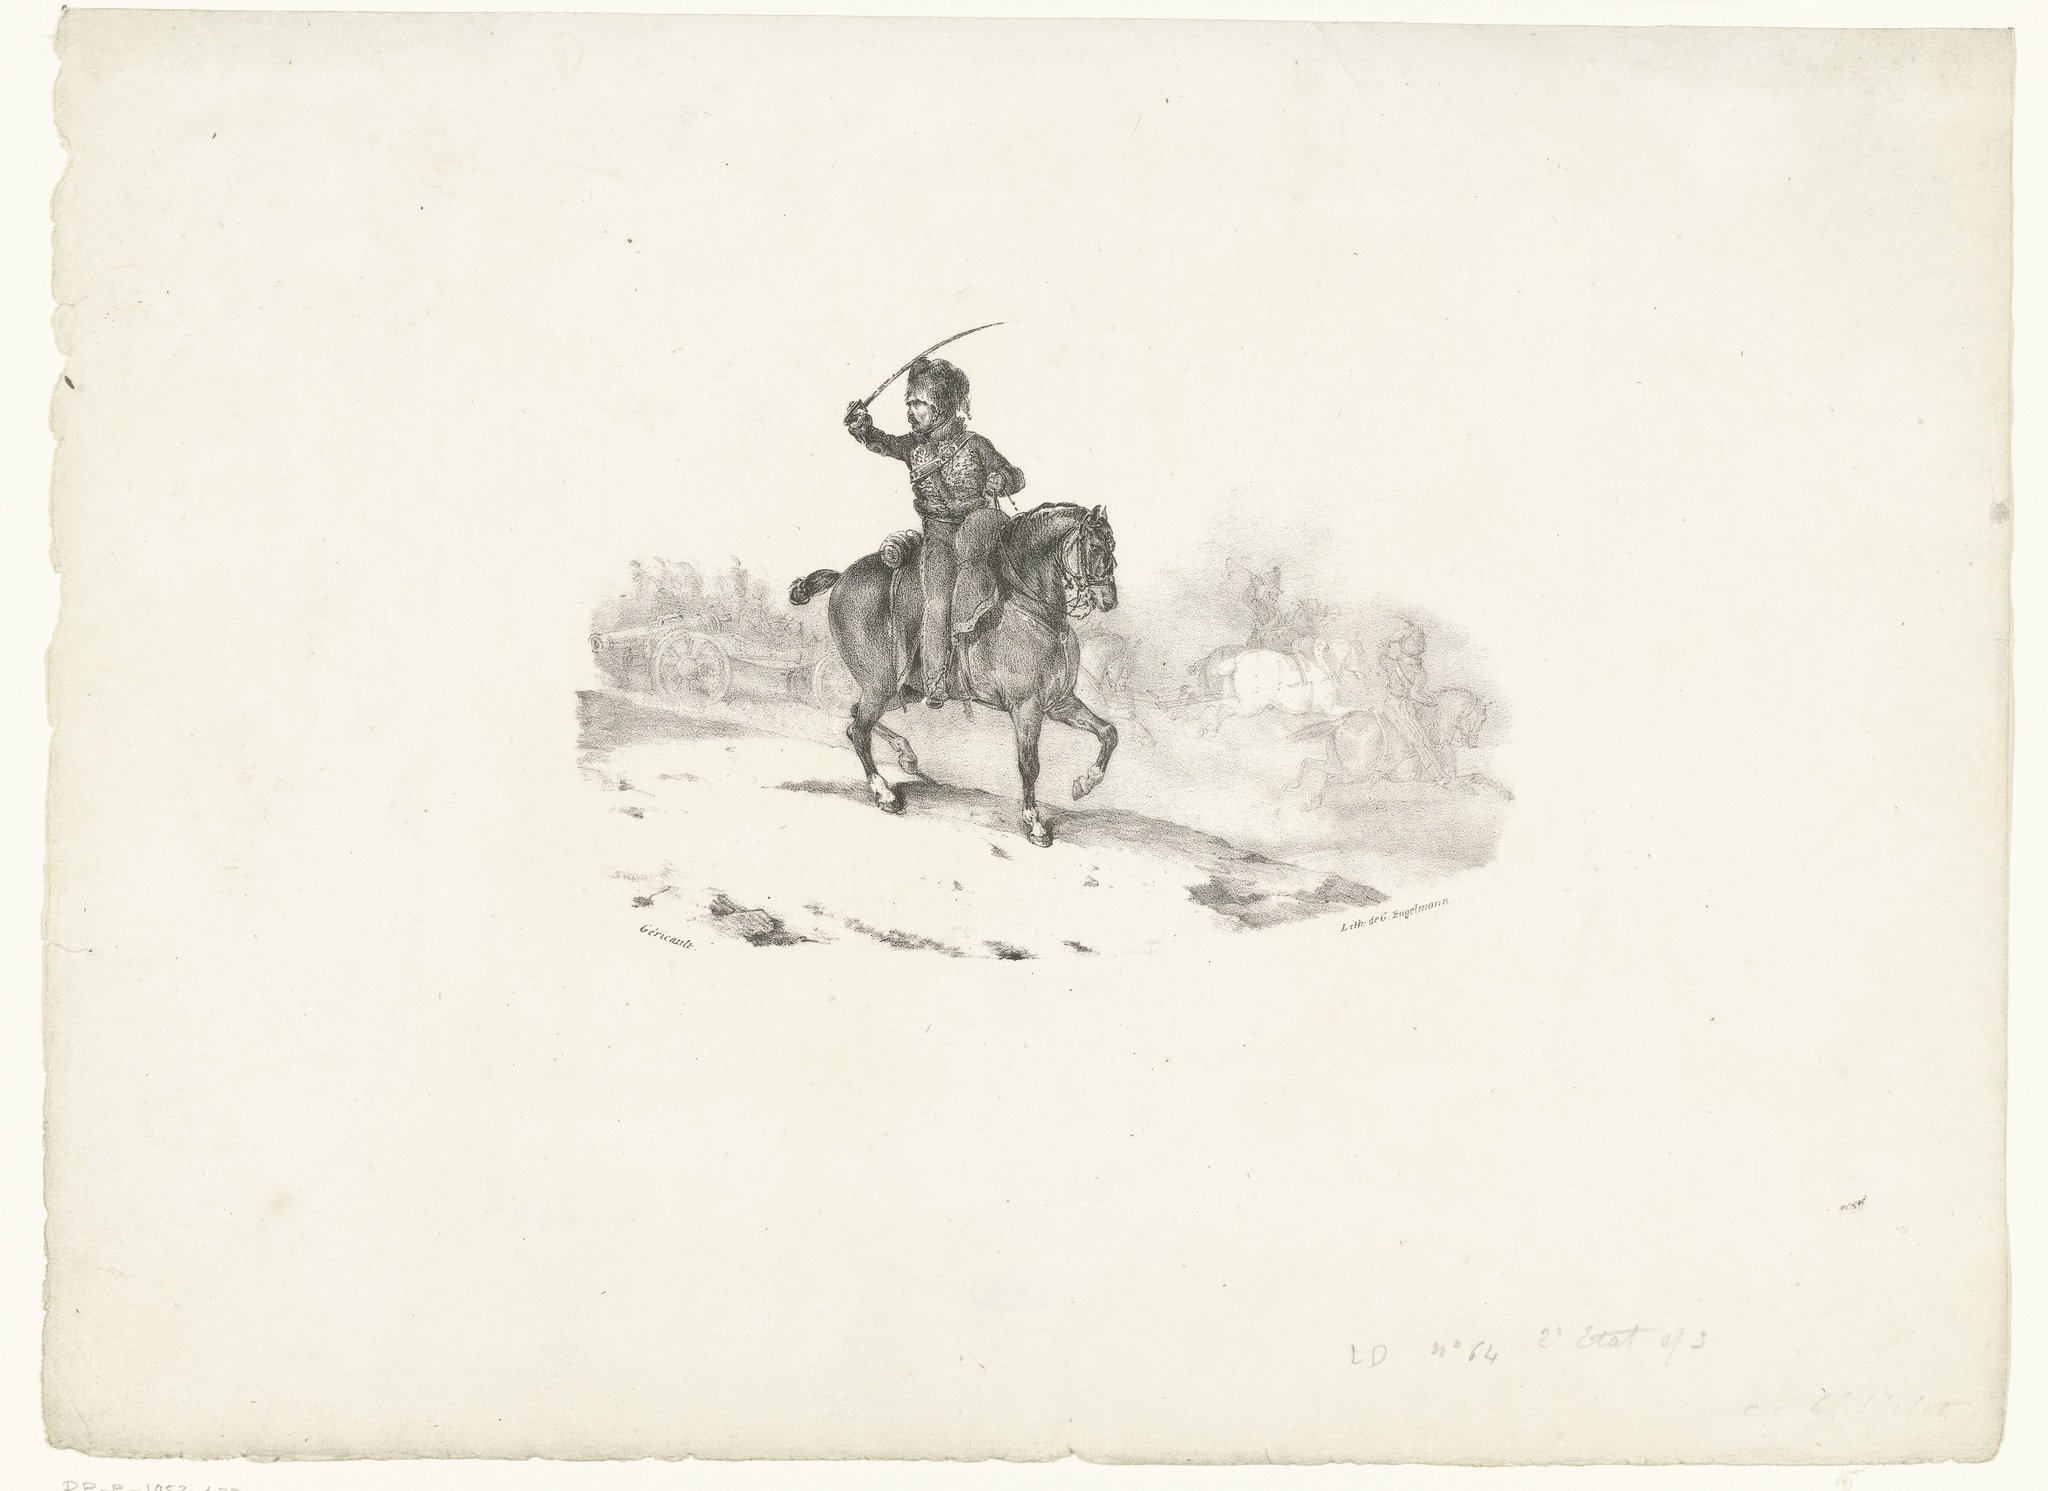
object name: print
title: Officier d'artillerie commandant la charge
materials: paper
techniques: lithograph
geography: paris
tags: warfare; military affairs (+ cavalry, horsemen), warfare; military affairs (+ officers), warfare; military affairs (+ artillery)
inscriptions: collector's mark: Lugt 2760, collector's mark: Lugt 2228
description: De officier van de artillerie te paard, in zijn rechterhand een opgeheven sabel. Achter hem een wagen met een kanon getrokken door paarden.